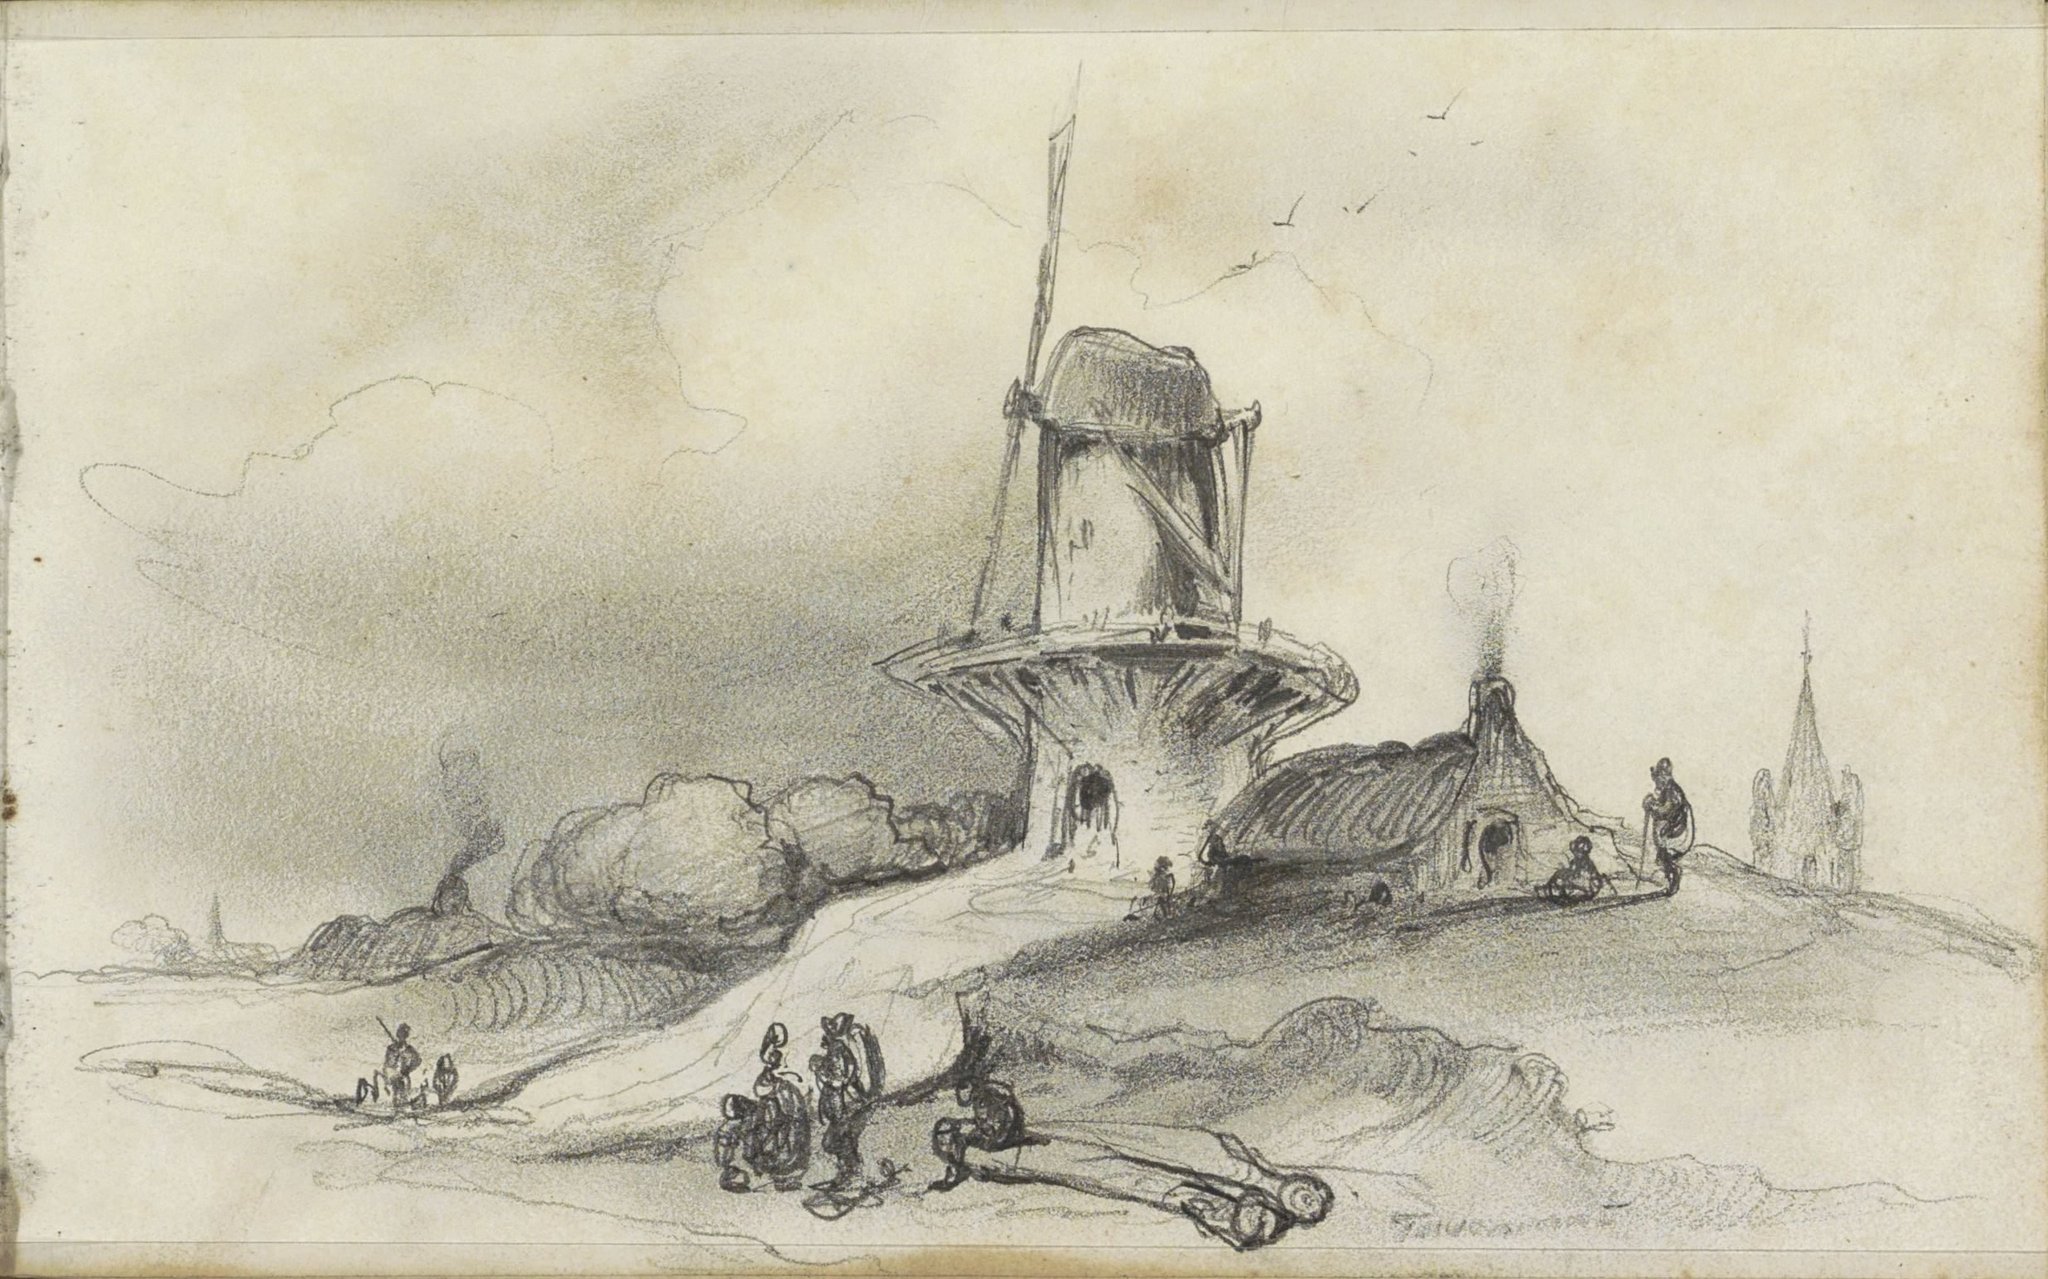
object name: sketchbook leaf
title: Landschap met figuren bij een molen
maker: johannes tavenraat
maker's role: draughtsman, painter, print maker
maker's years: 1809-1881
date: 1843-1844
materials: paper, pencil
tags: windmill in landscape, landscapes (+ landscape with figures, staffage)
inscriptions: signature: ‘Tavenraat’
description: Blad 4 recto uit een schetsboek met 38 bladen.